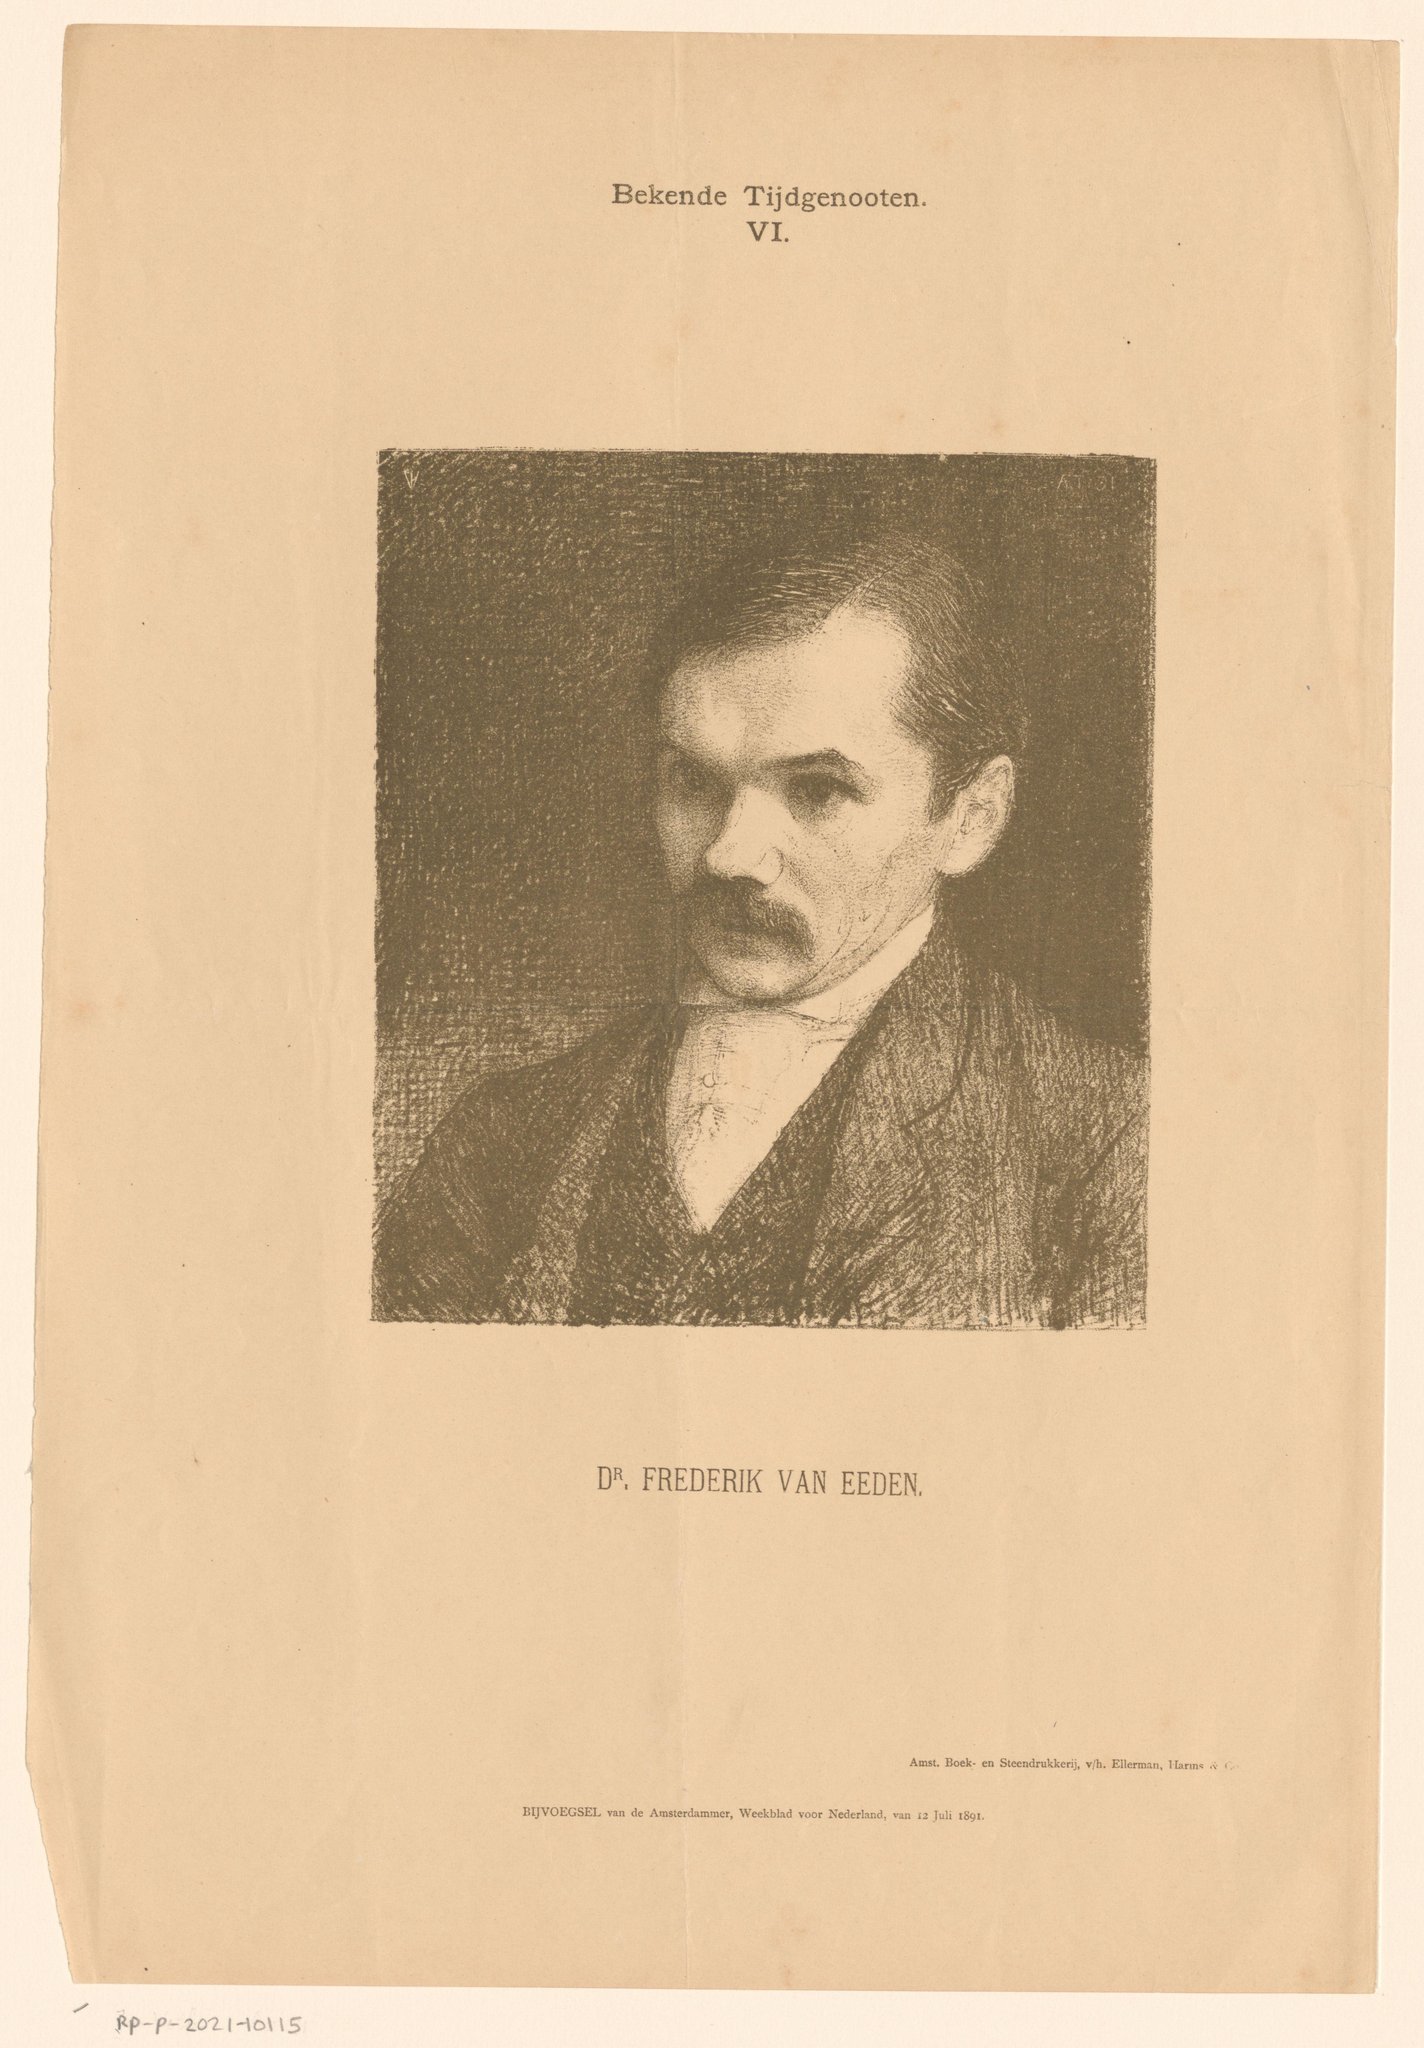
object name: print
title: Portretten van bekende personen uit de negentiende eeuw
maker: jan veth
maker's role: designer, draughtsman, painter, print maker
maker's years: 1864-1925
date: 1891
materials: paper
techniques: lithograph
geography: amsterdam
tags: frederik van eeden, historical persons, portrait of a writer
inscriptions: inscription: ‘uit kelderdépôt 2002’, collector's mark: Lugt 2228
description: Deze prent werd uitgegeven als bijvoegsel van De Amsterdammer op 12 juli 1891.